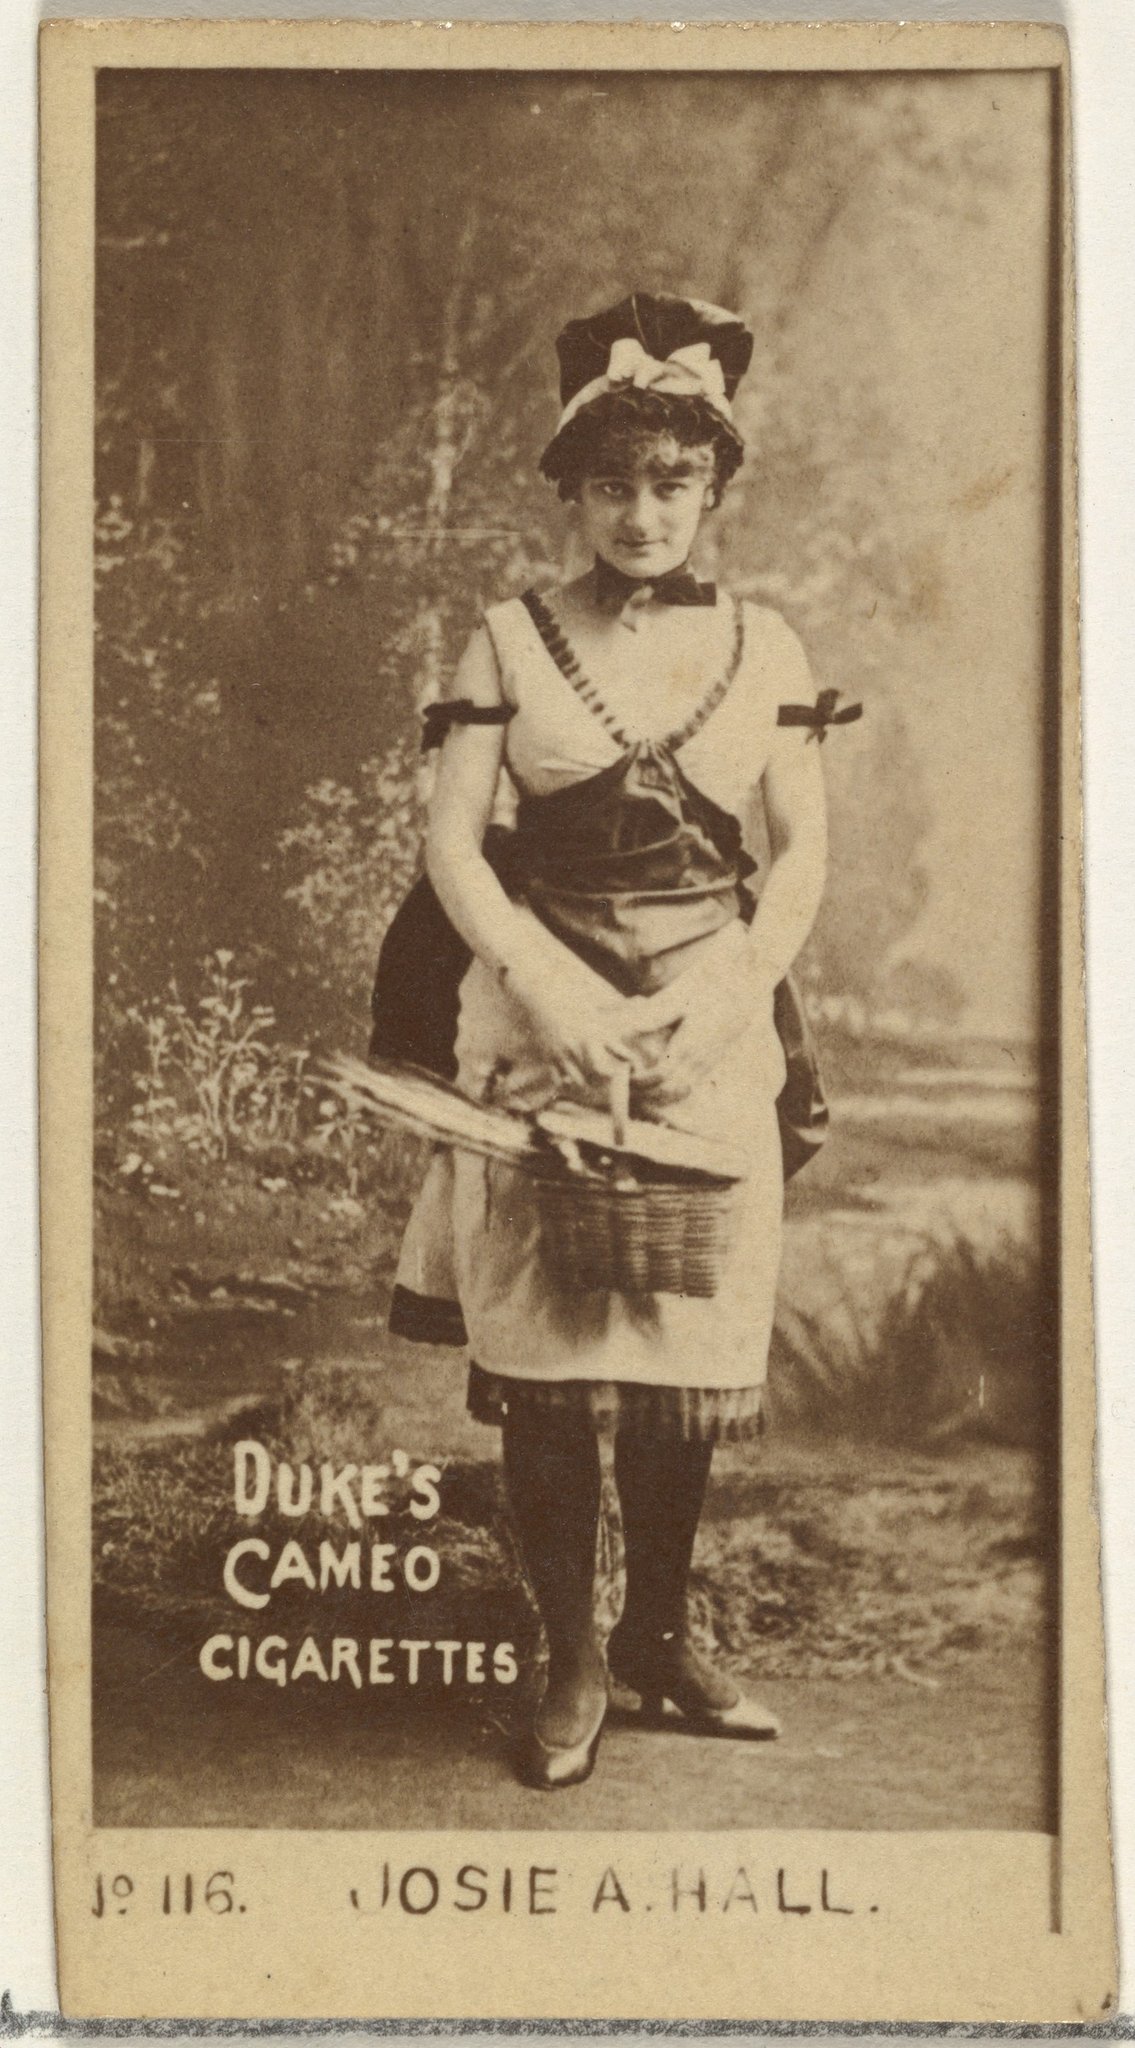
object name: photograph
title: Card Number 116, Josie Hall, from the Actors and Actresses series (N145-4) issued by Duke Sons & Co. to promote Cameo Cigarettes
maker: w. duke, sons & co.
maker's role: publisher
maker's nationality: american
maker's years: 1870-1920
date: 1880-1889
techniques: albumen silver print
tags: portraits,women,actresses